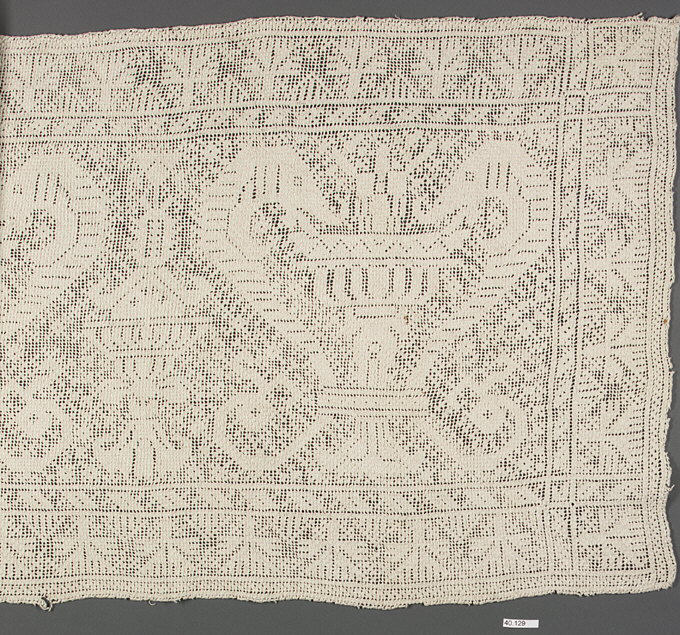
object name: panel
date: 1501-1700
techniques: embroidery